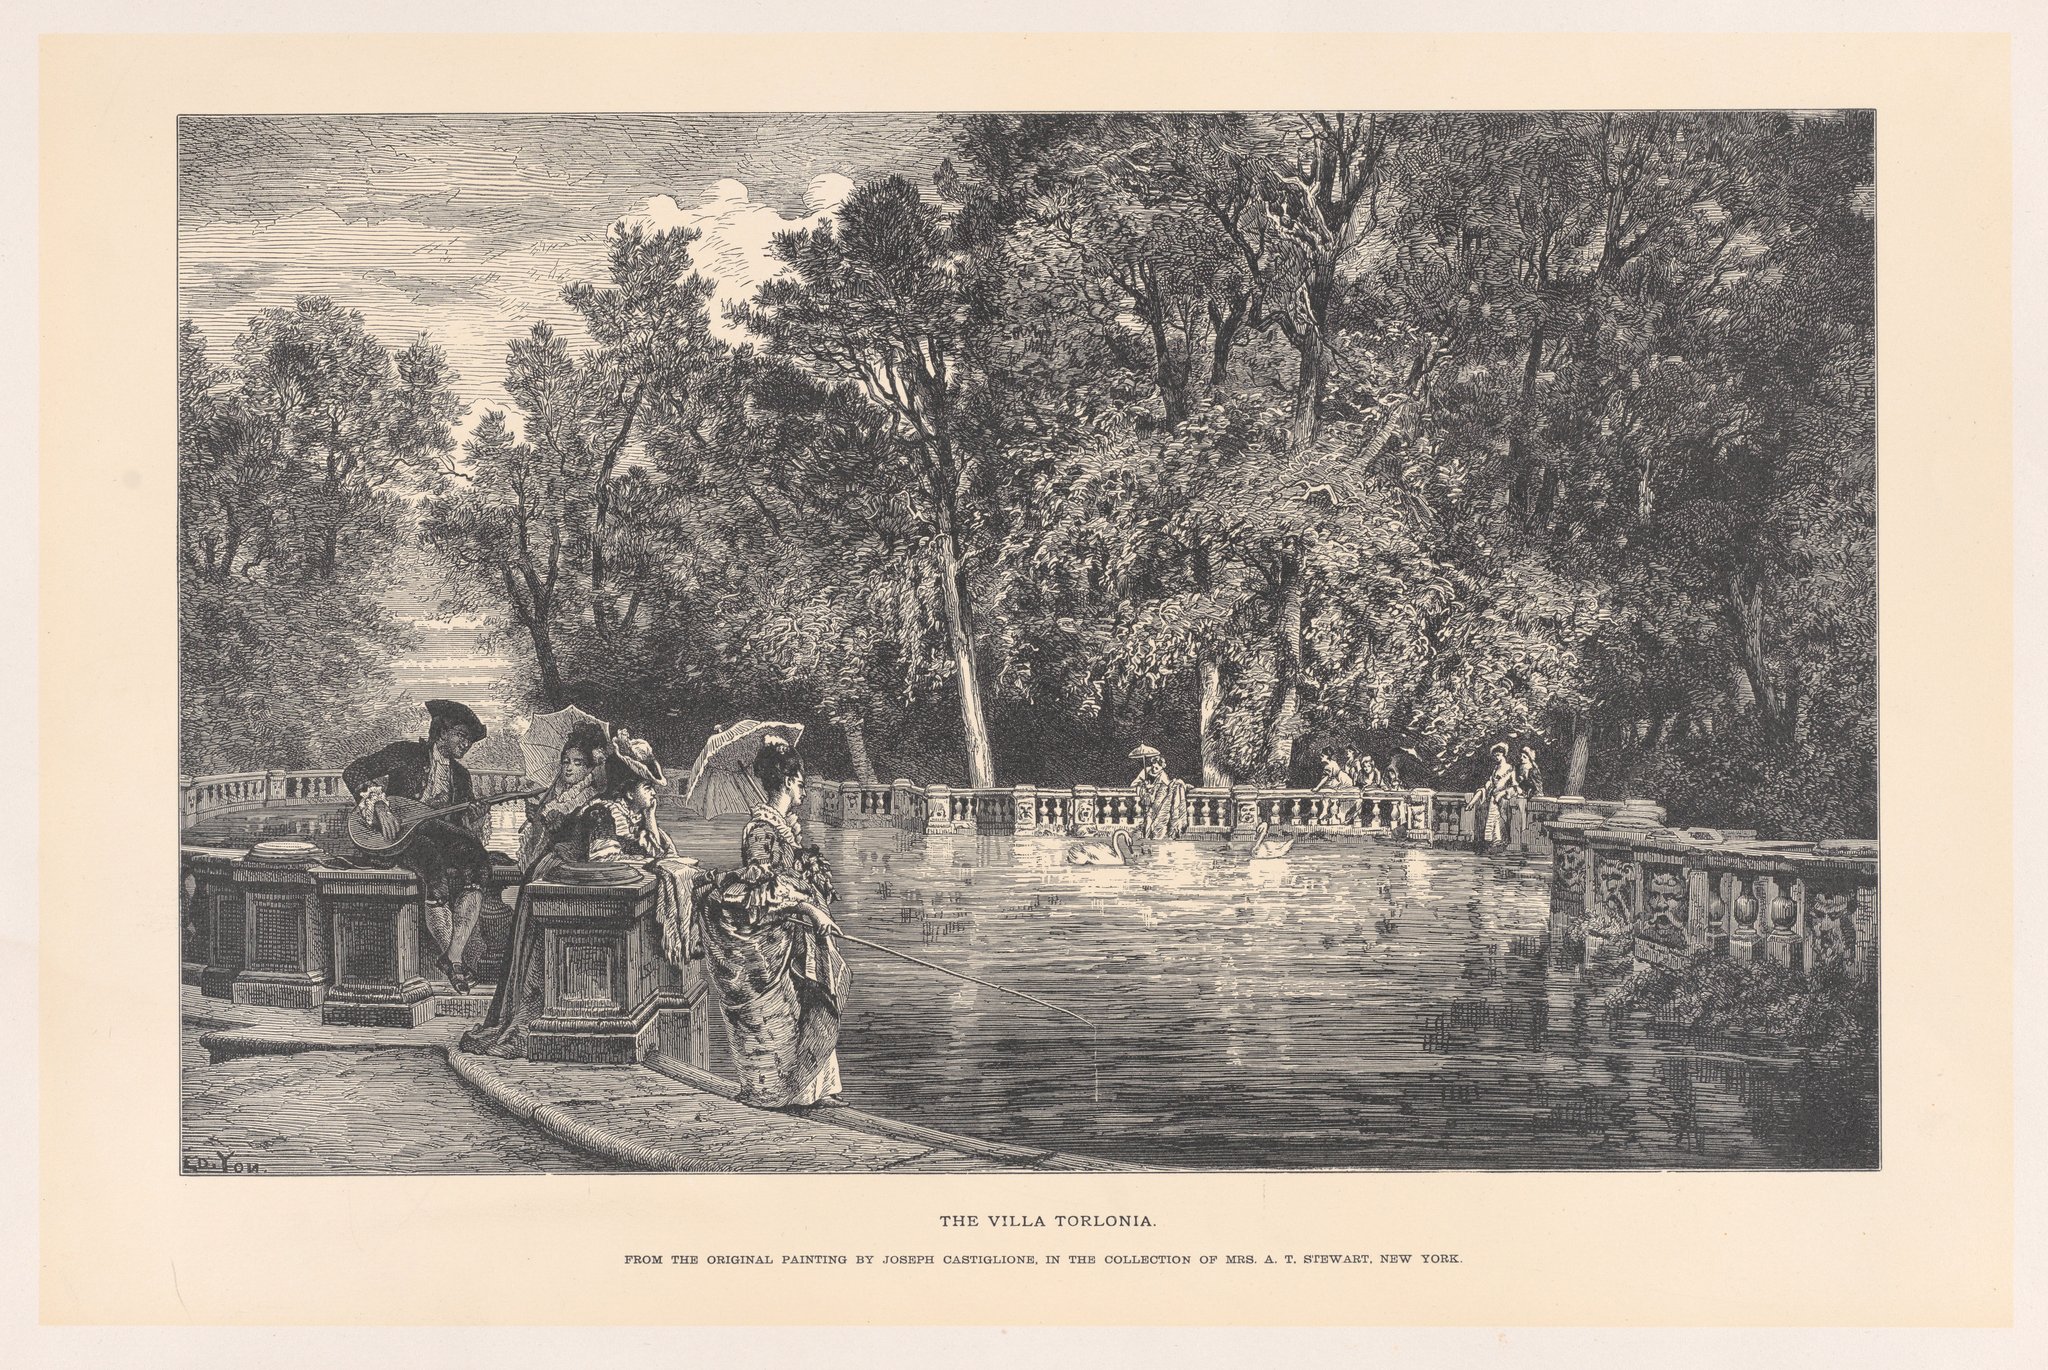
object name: print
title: The Villa Torlonia, from the original painting by Joseph Castiglione in the collection of Mrs. A. T. Stewart, New York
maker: edmond yon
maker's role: artist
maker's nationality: french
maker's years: 1836-1907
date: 1801-1900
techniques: engraving